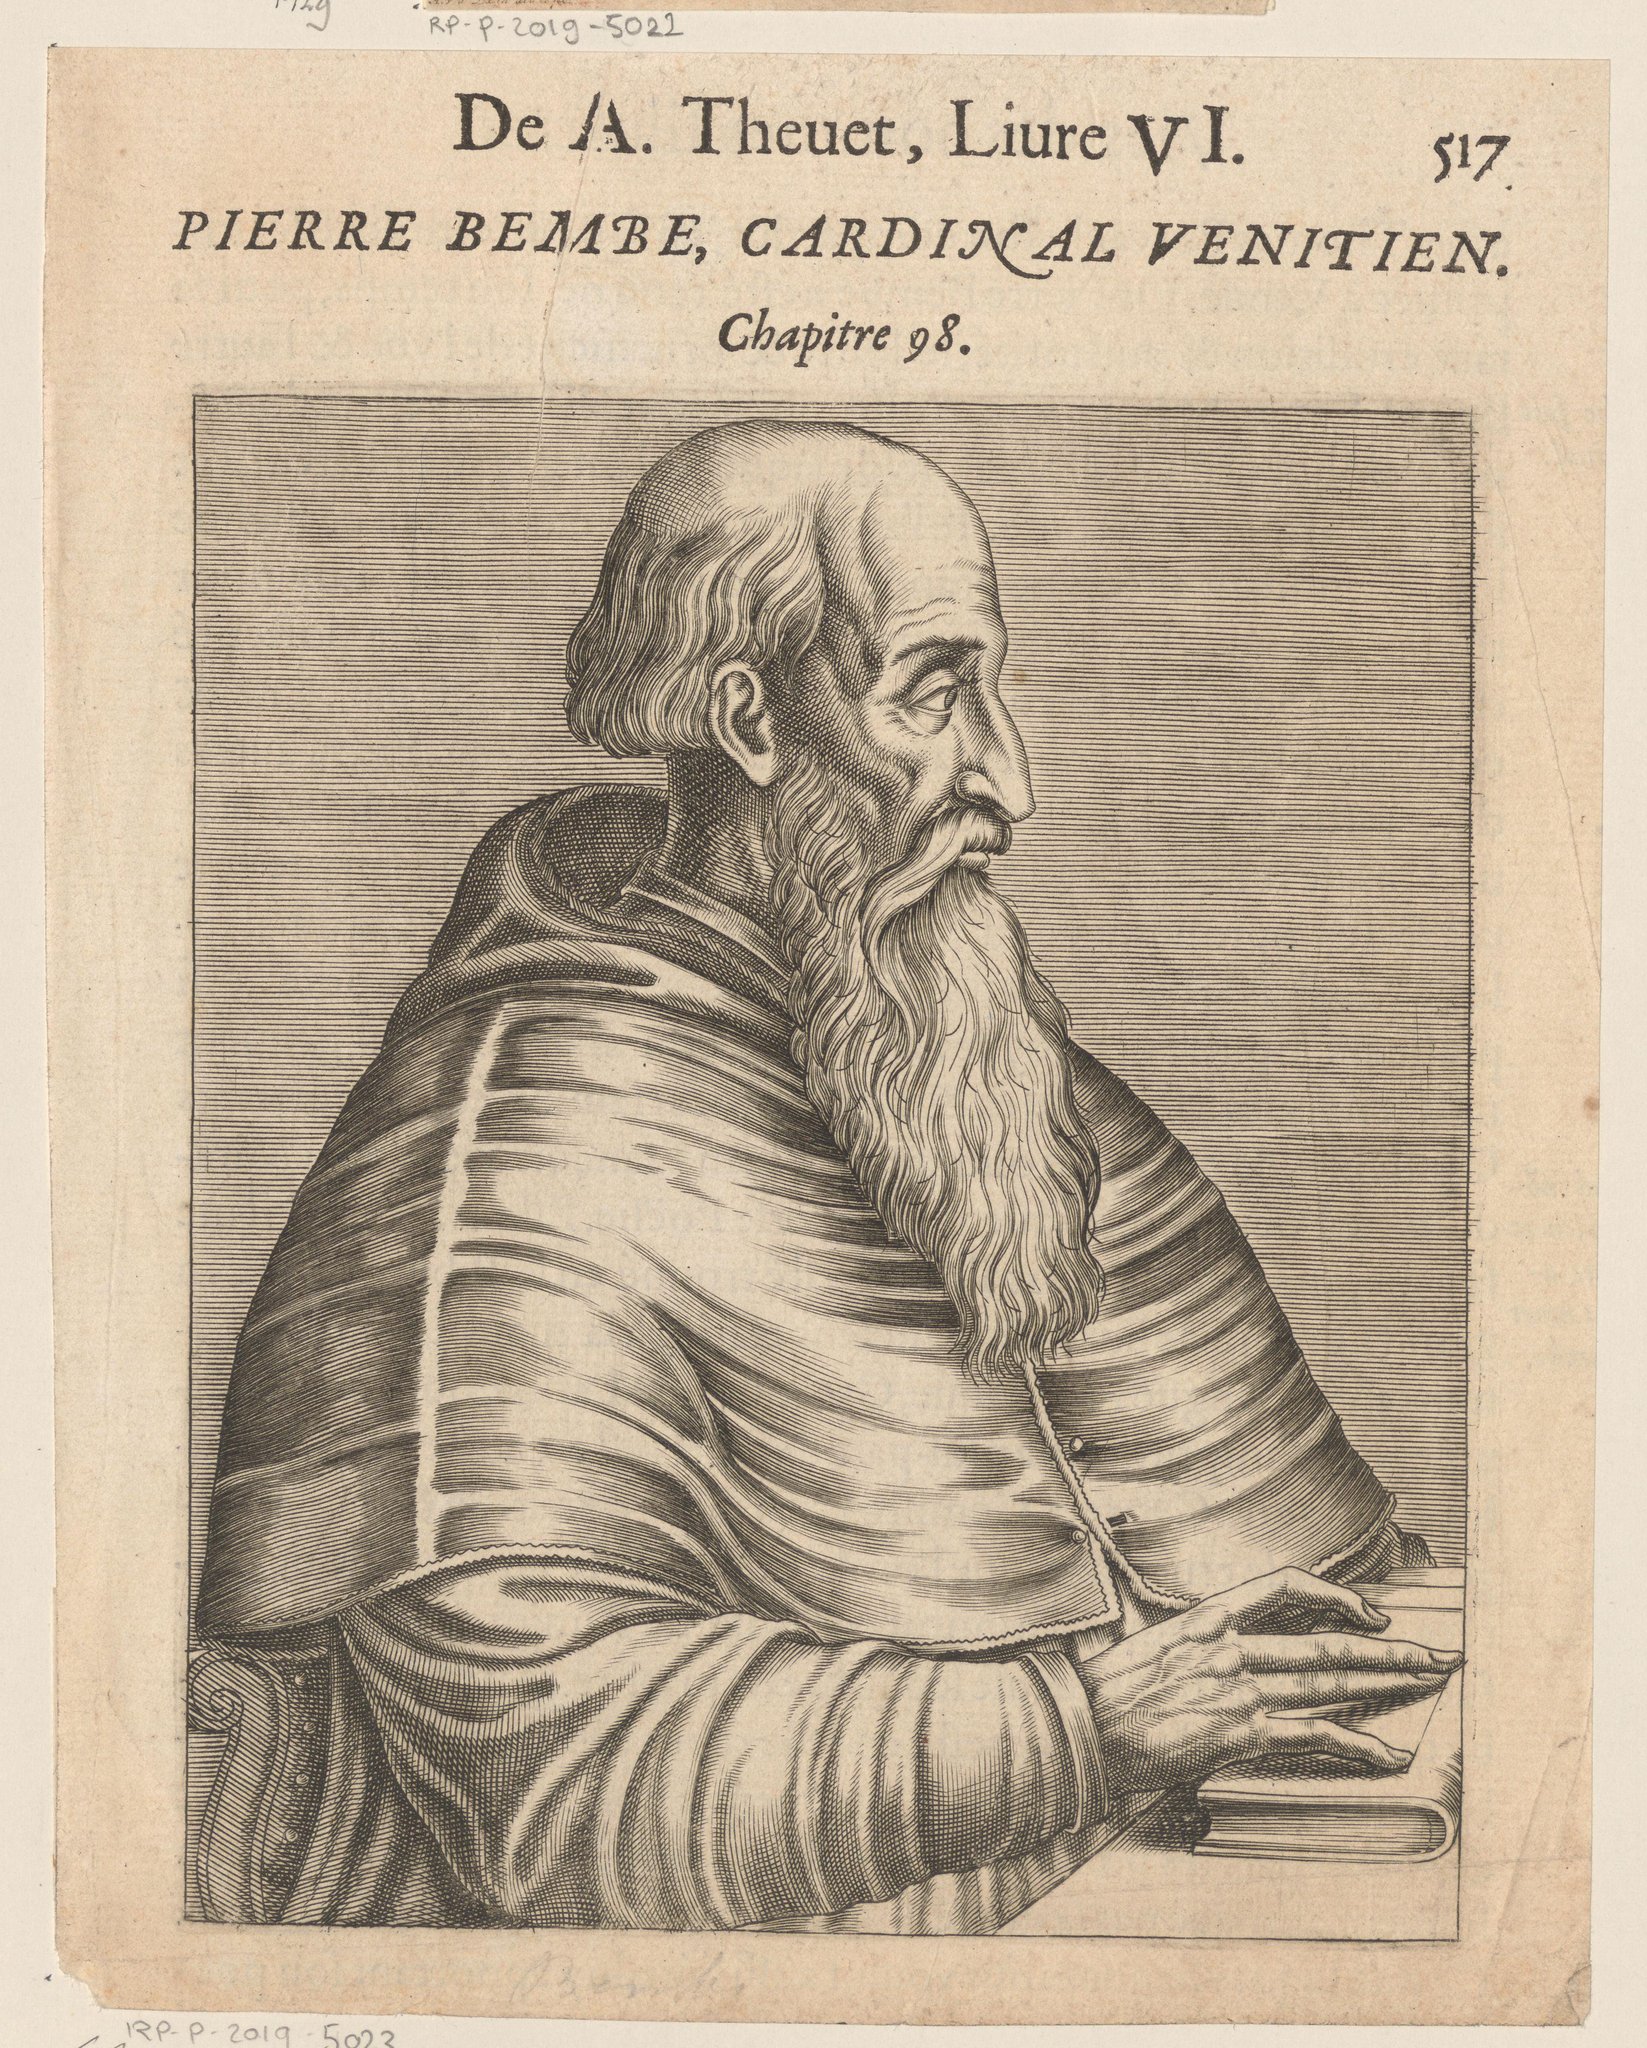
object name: print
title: Portret van Pietro Bembo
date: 1584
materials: paper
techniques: engraving, etching, letterpress printing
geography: paris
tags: venice, rome, cardinal, historical persons, book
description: Prent uit: Thevet, André. Les vrais pourtraits et vies des hommes illustres grecz, latins et payens (...). Parijs: weduwe Jacques Kerver en Guillaume Chaudière, 1584, dl. 2, f. 517.